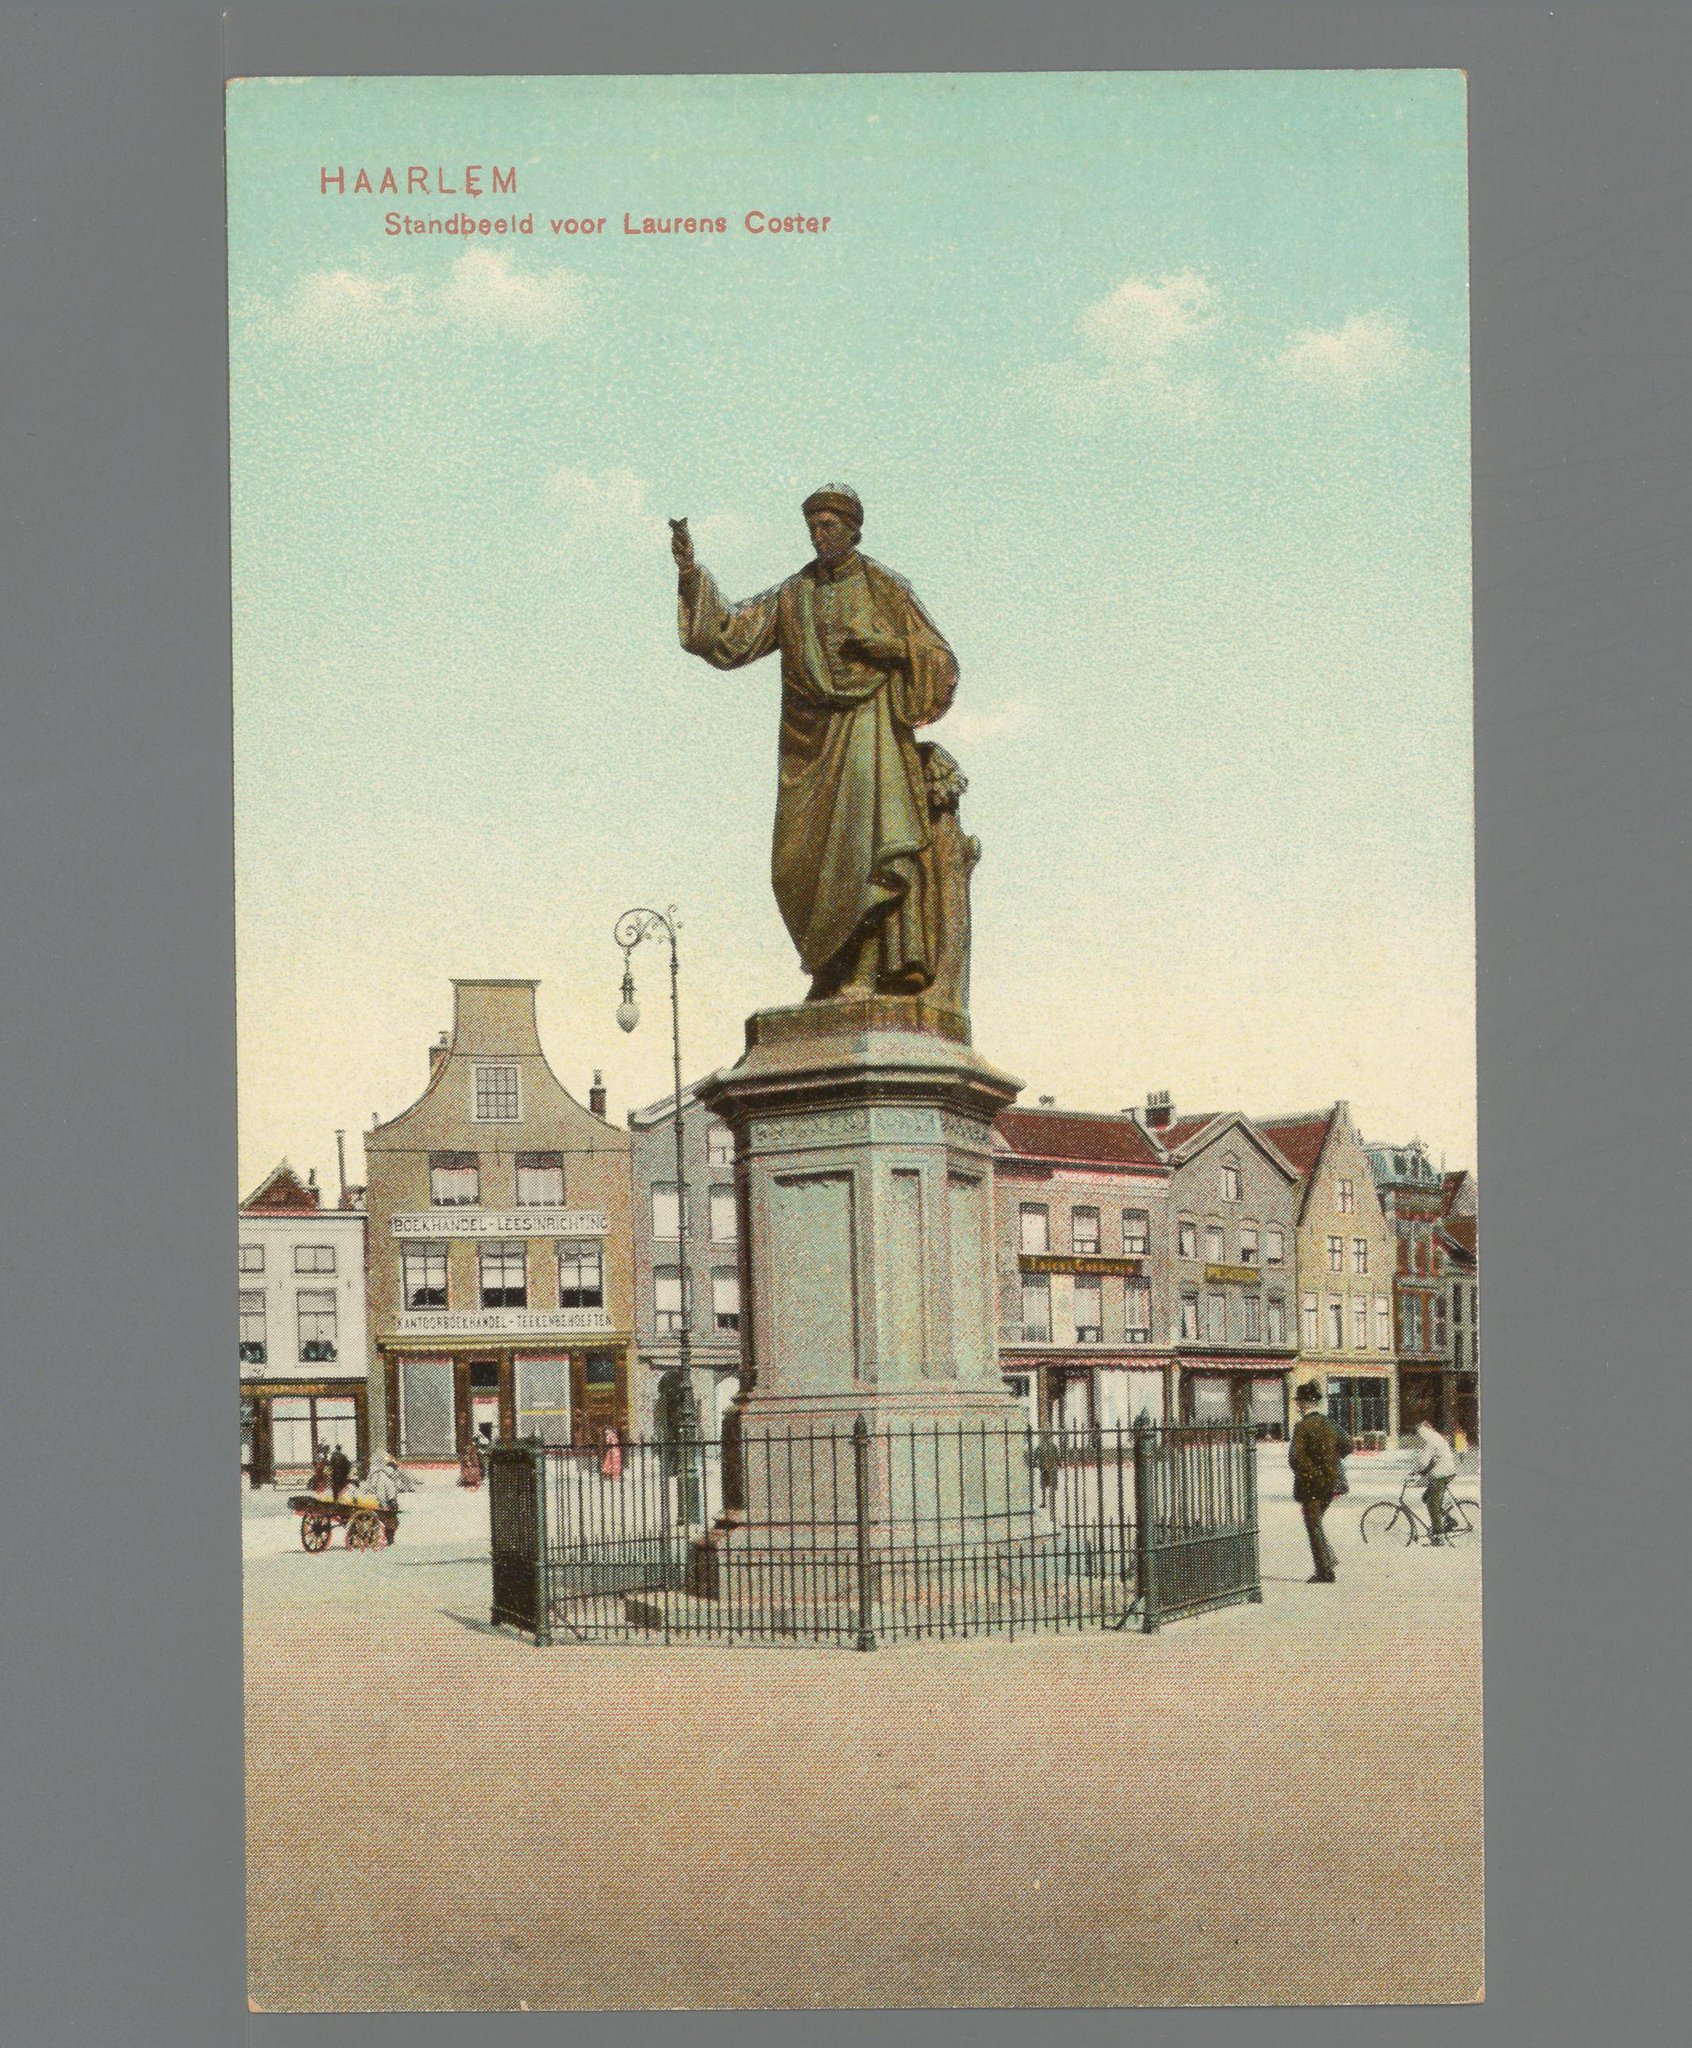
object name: photomechanical print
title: Haarlem. Standbeeld voor Laurens Coster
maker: Anonymous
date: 1909-1918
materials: cardboard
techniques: lithograph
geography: the hague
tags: square, place, circus, etc., monument, statue, haarlem